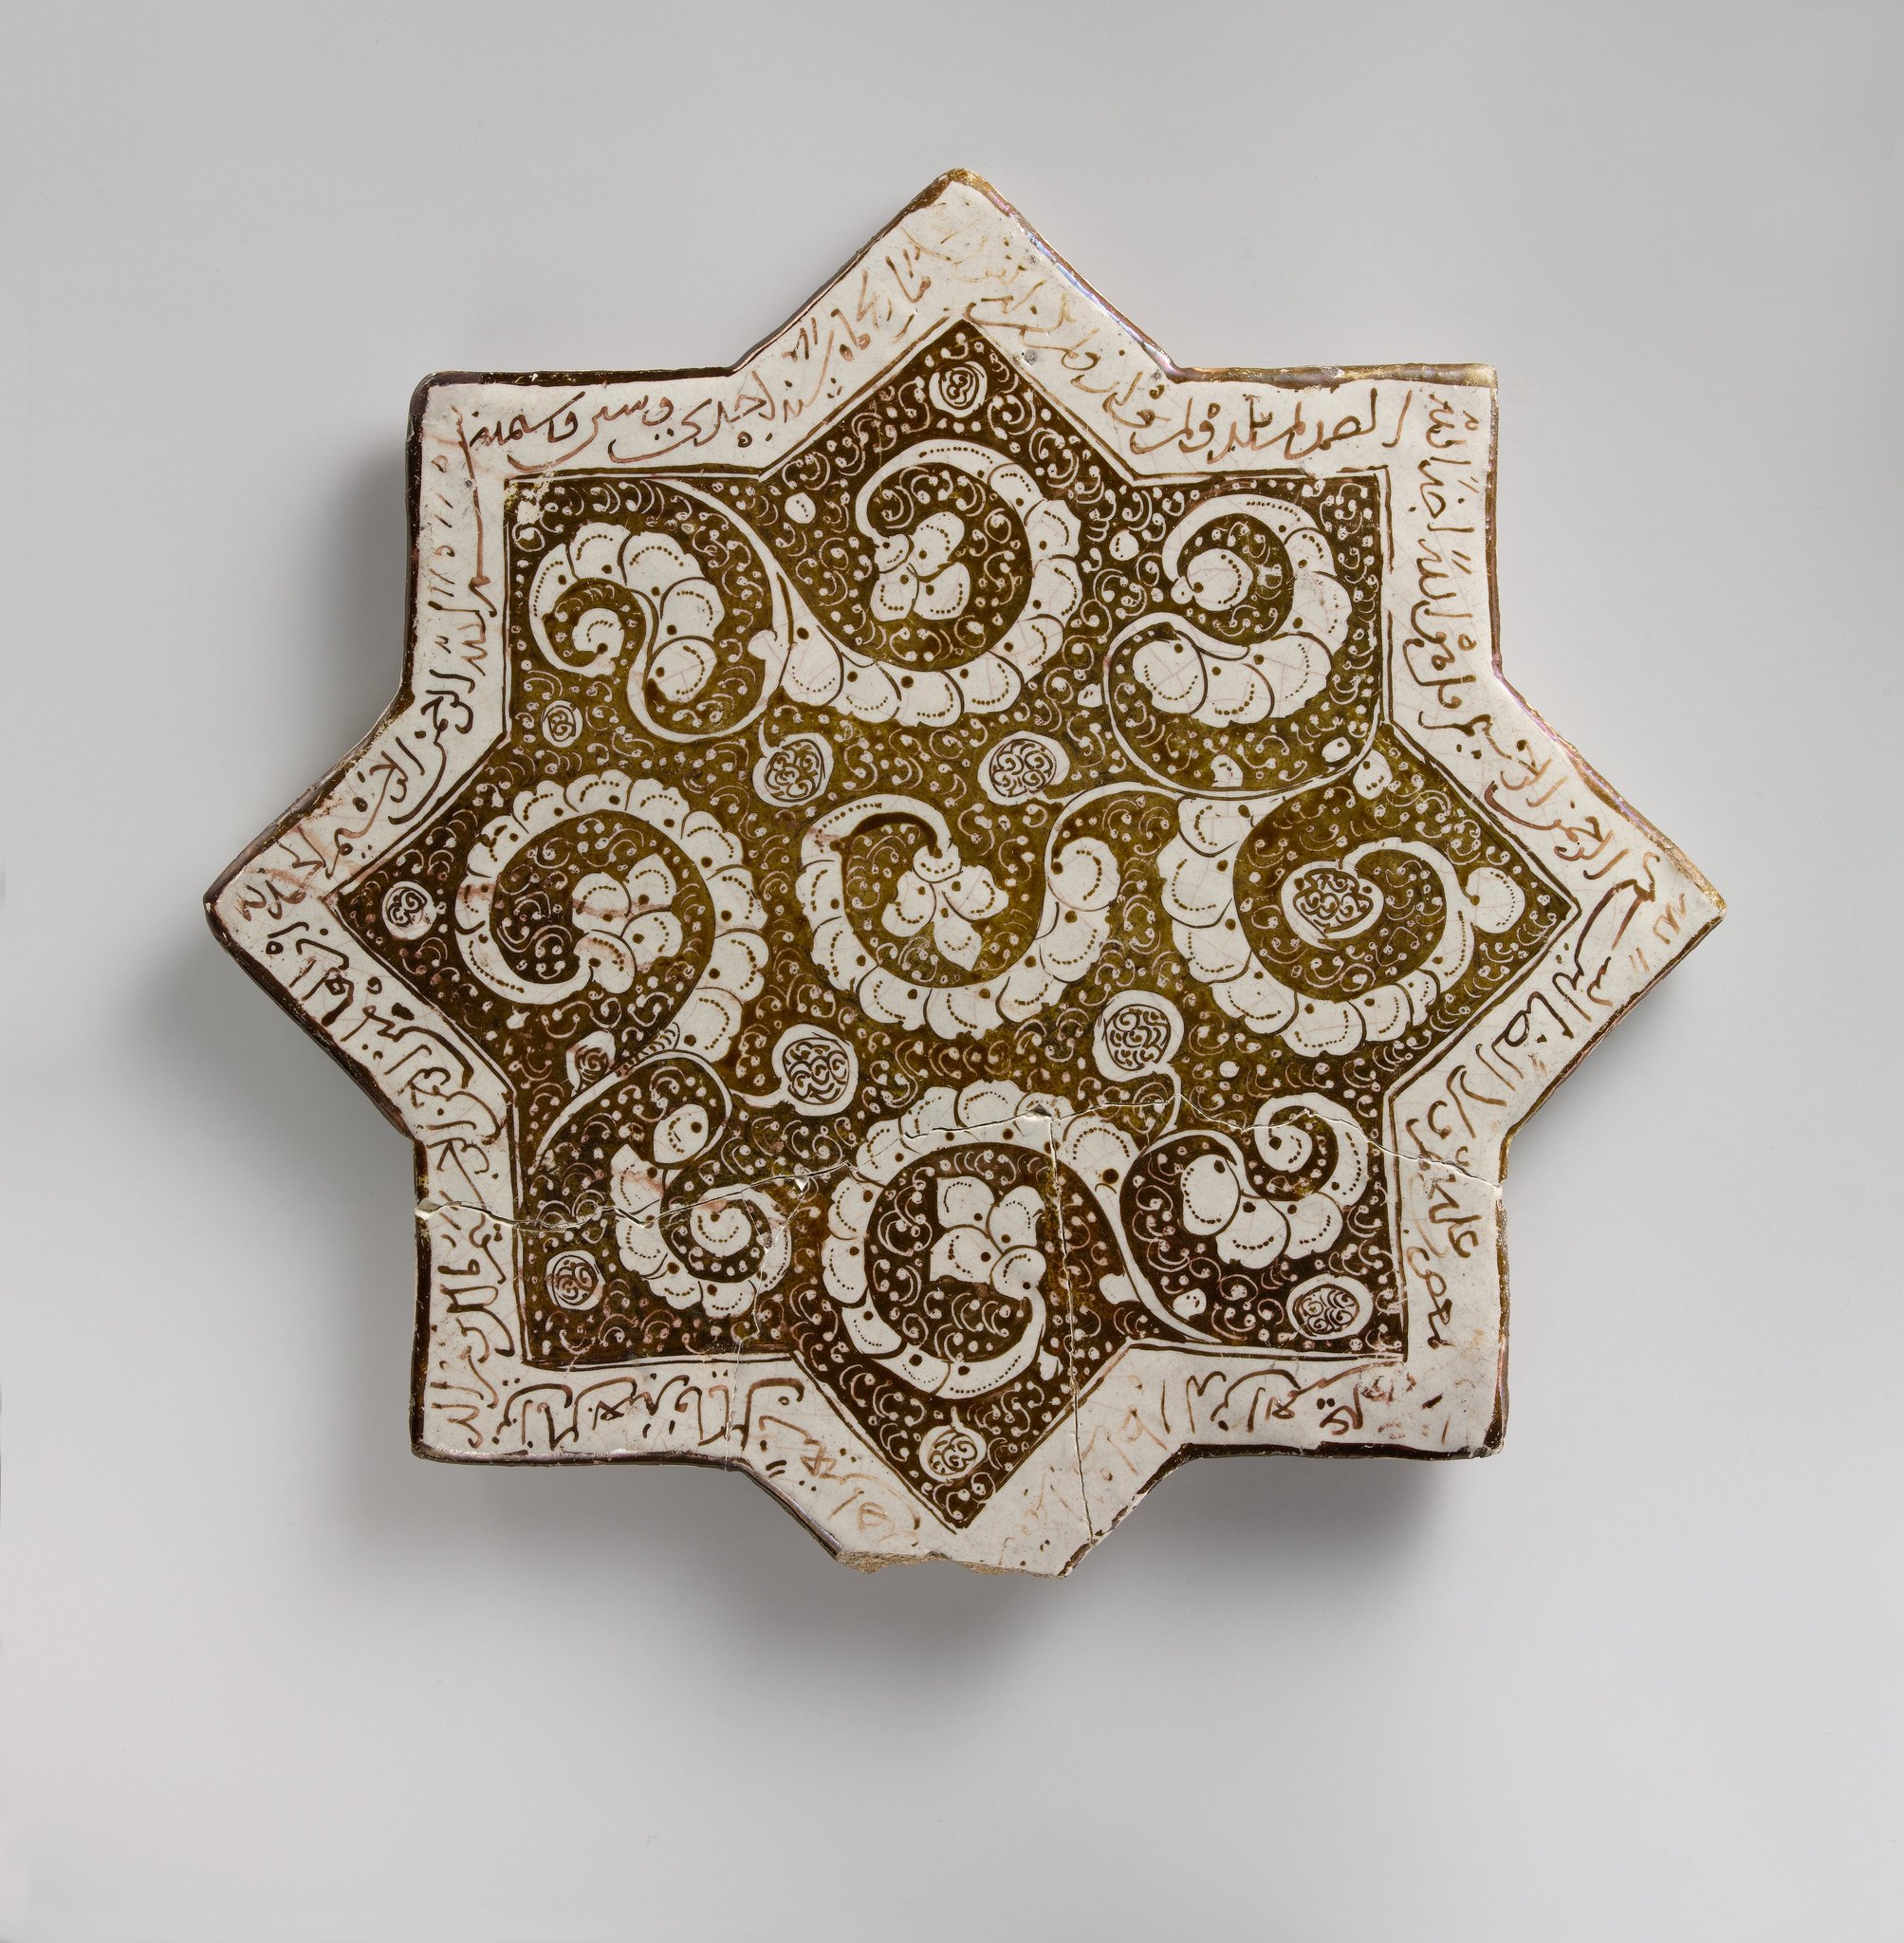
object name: star shaped tile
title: Star-Shaped Tile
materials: glaze, stonepaste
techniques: luster painting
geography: iran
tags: arabic